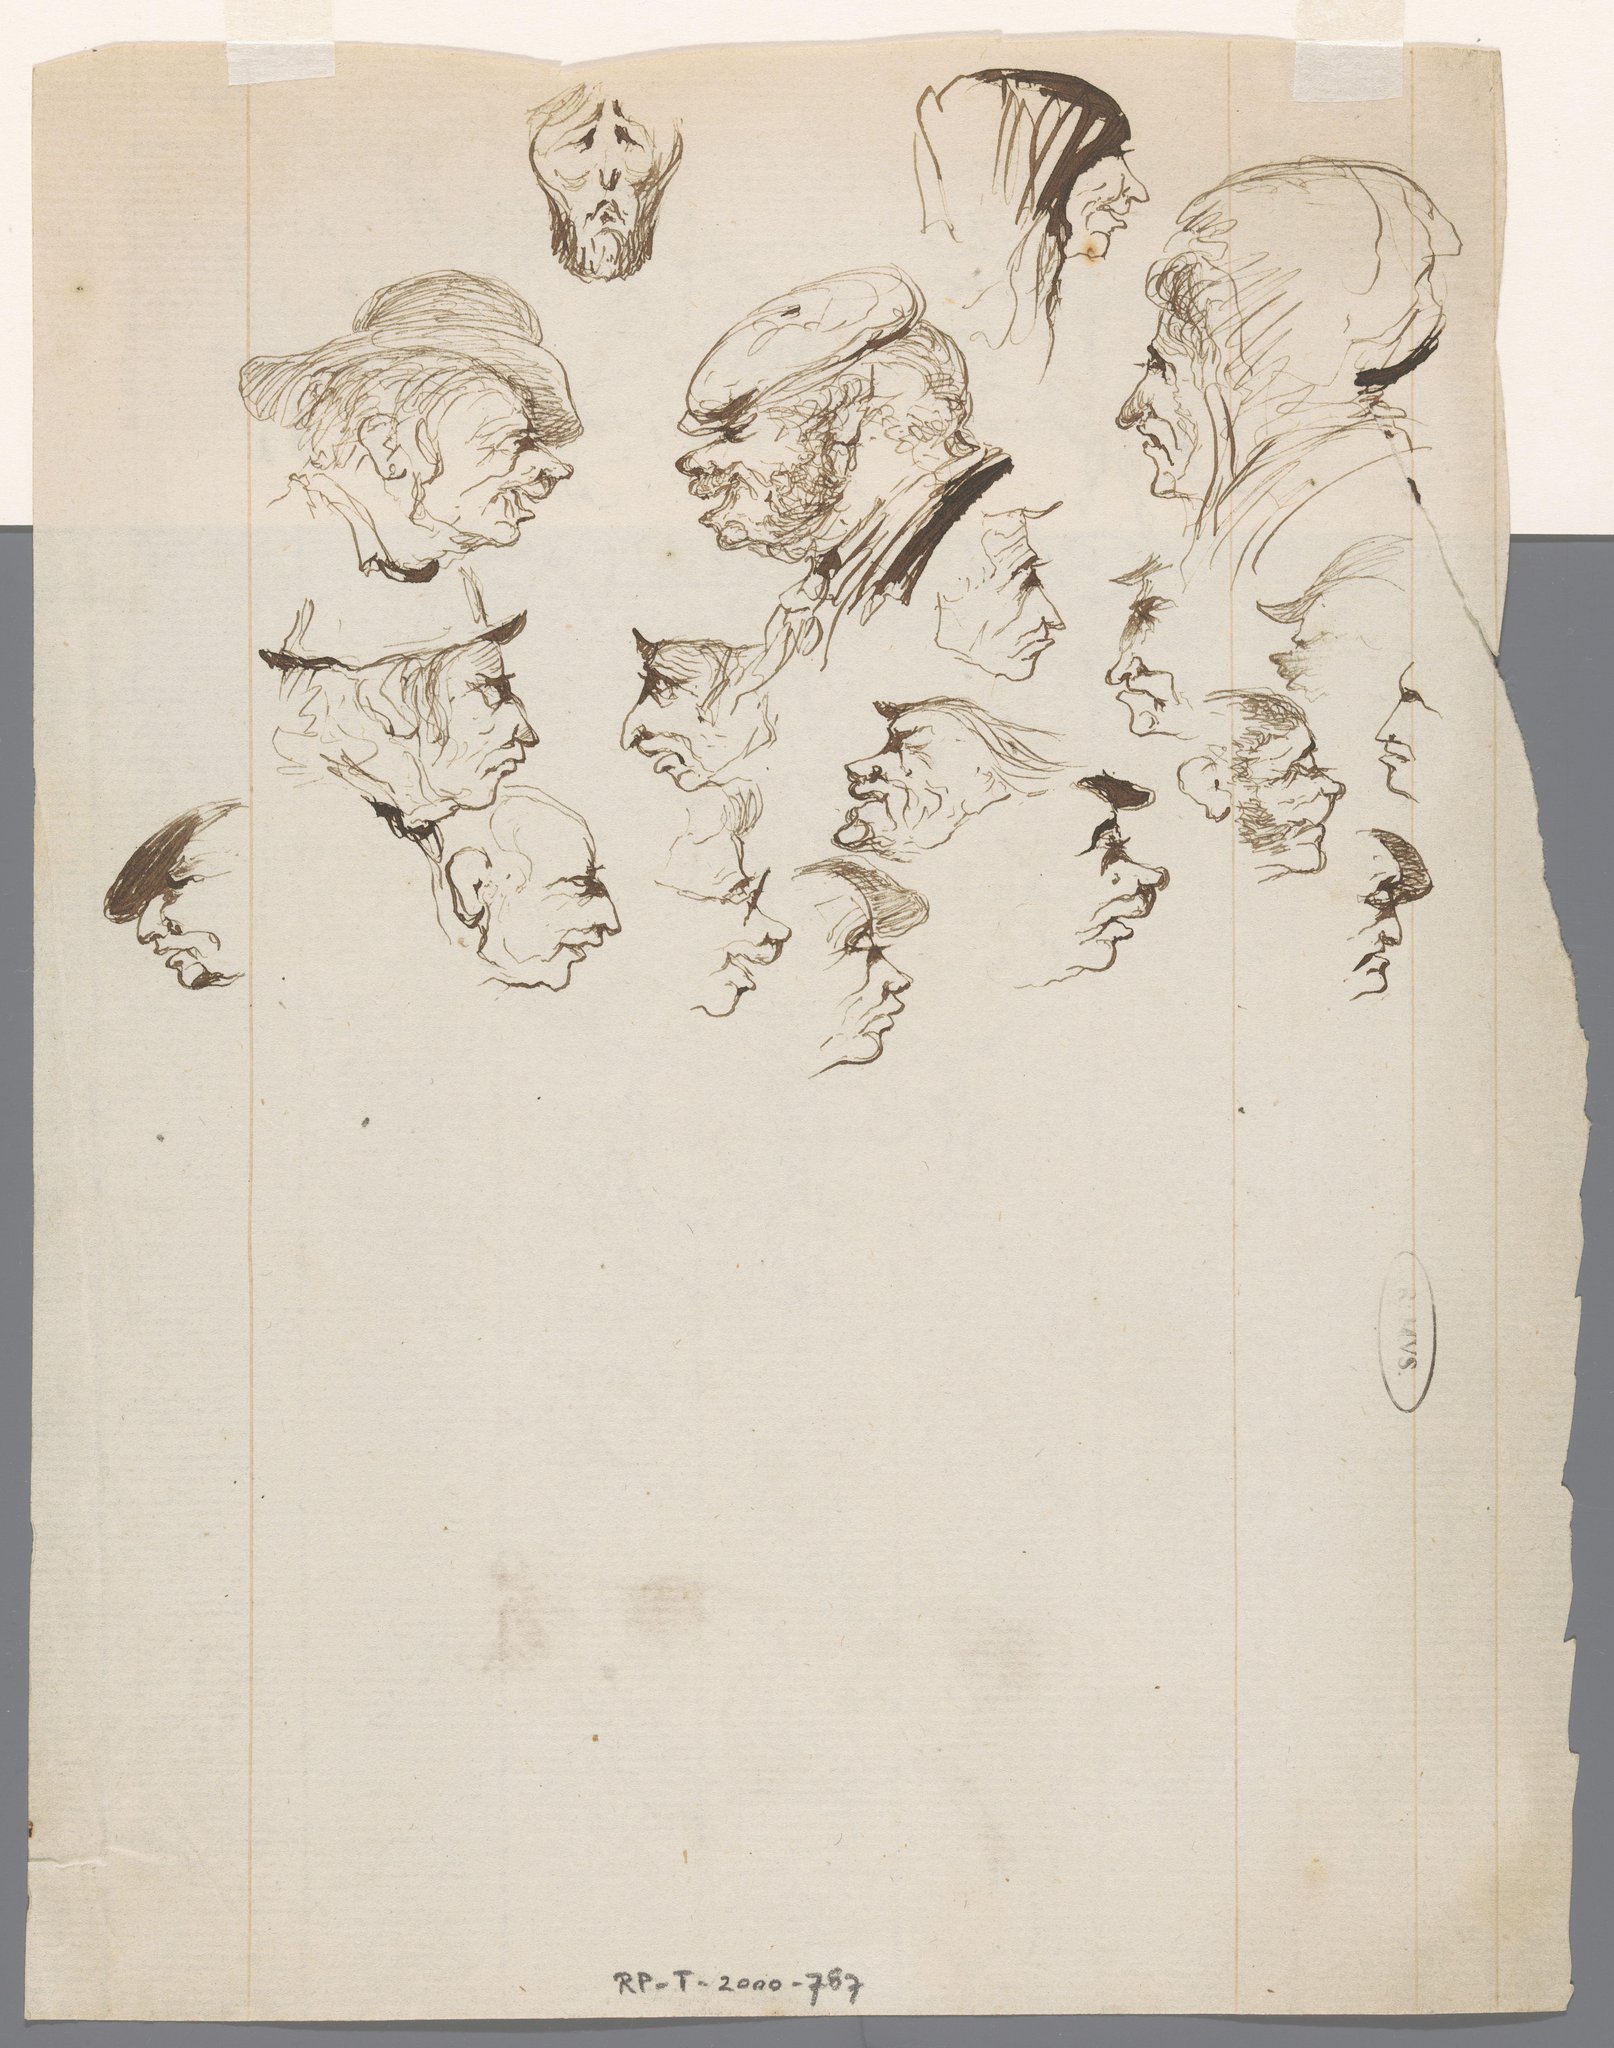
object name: drawing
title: Koppen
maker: johannes tavenraat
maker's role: draughtsman, painter, print maker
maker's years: 1809-1881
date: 1840-1880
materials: ink, paper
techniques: pen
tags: caricatures (human types)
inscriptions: collector's mark: Lugt 2228